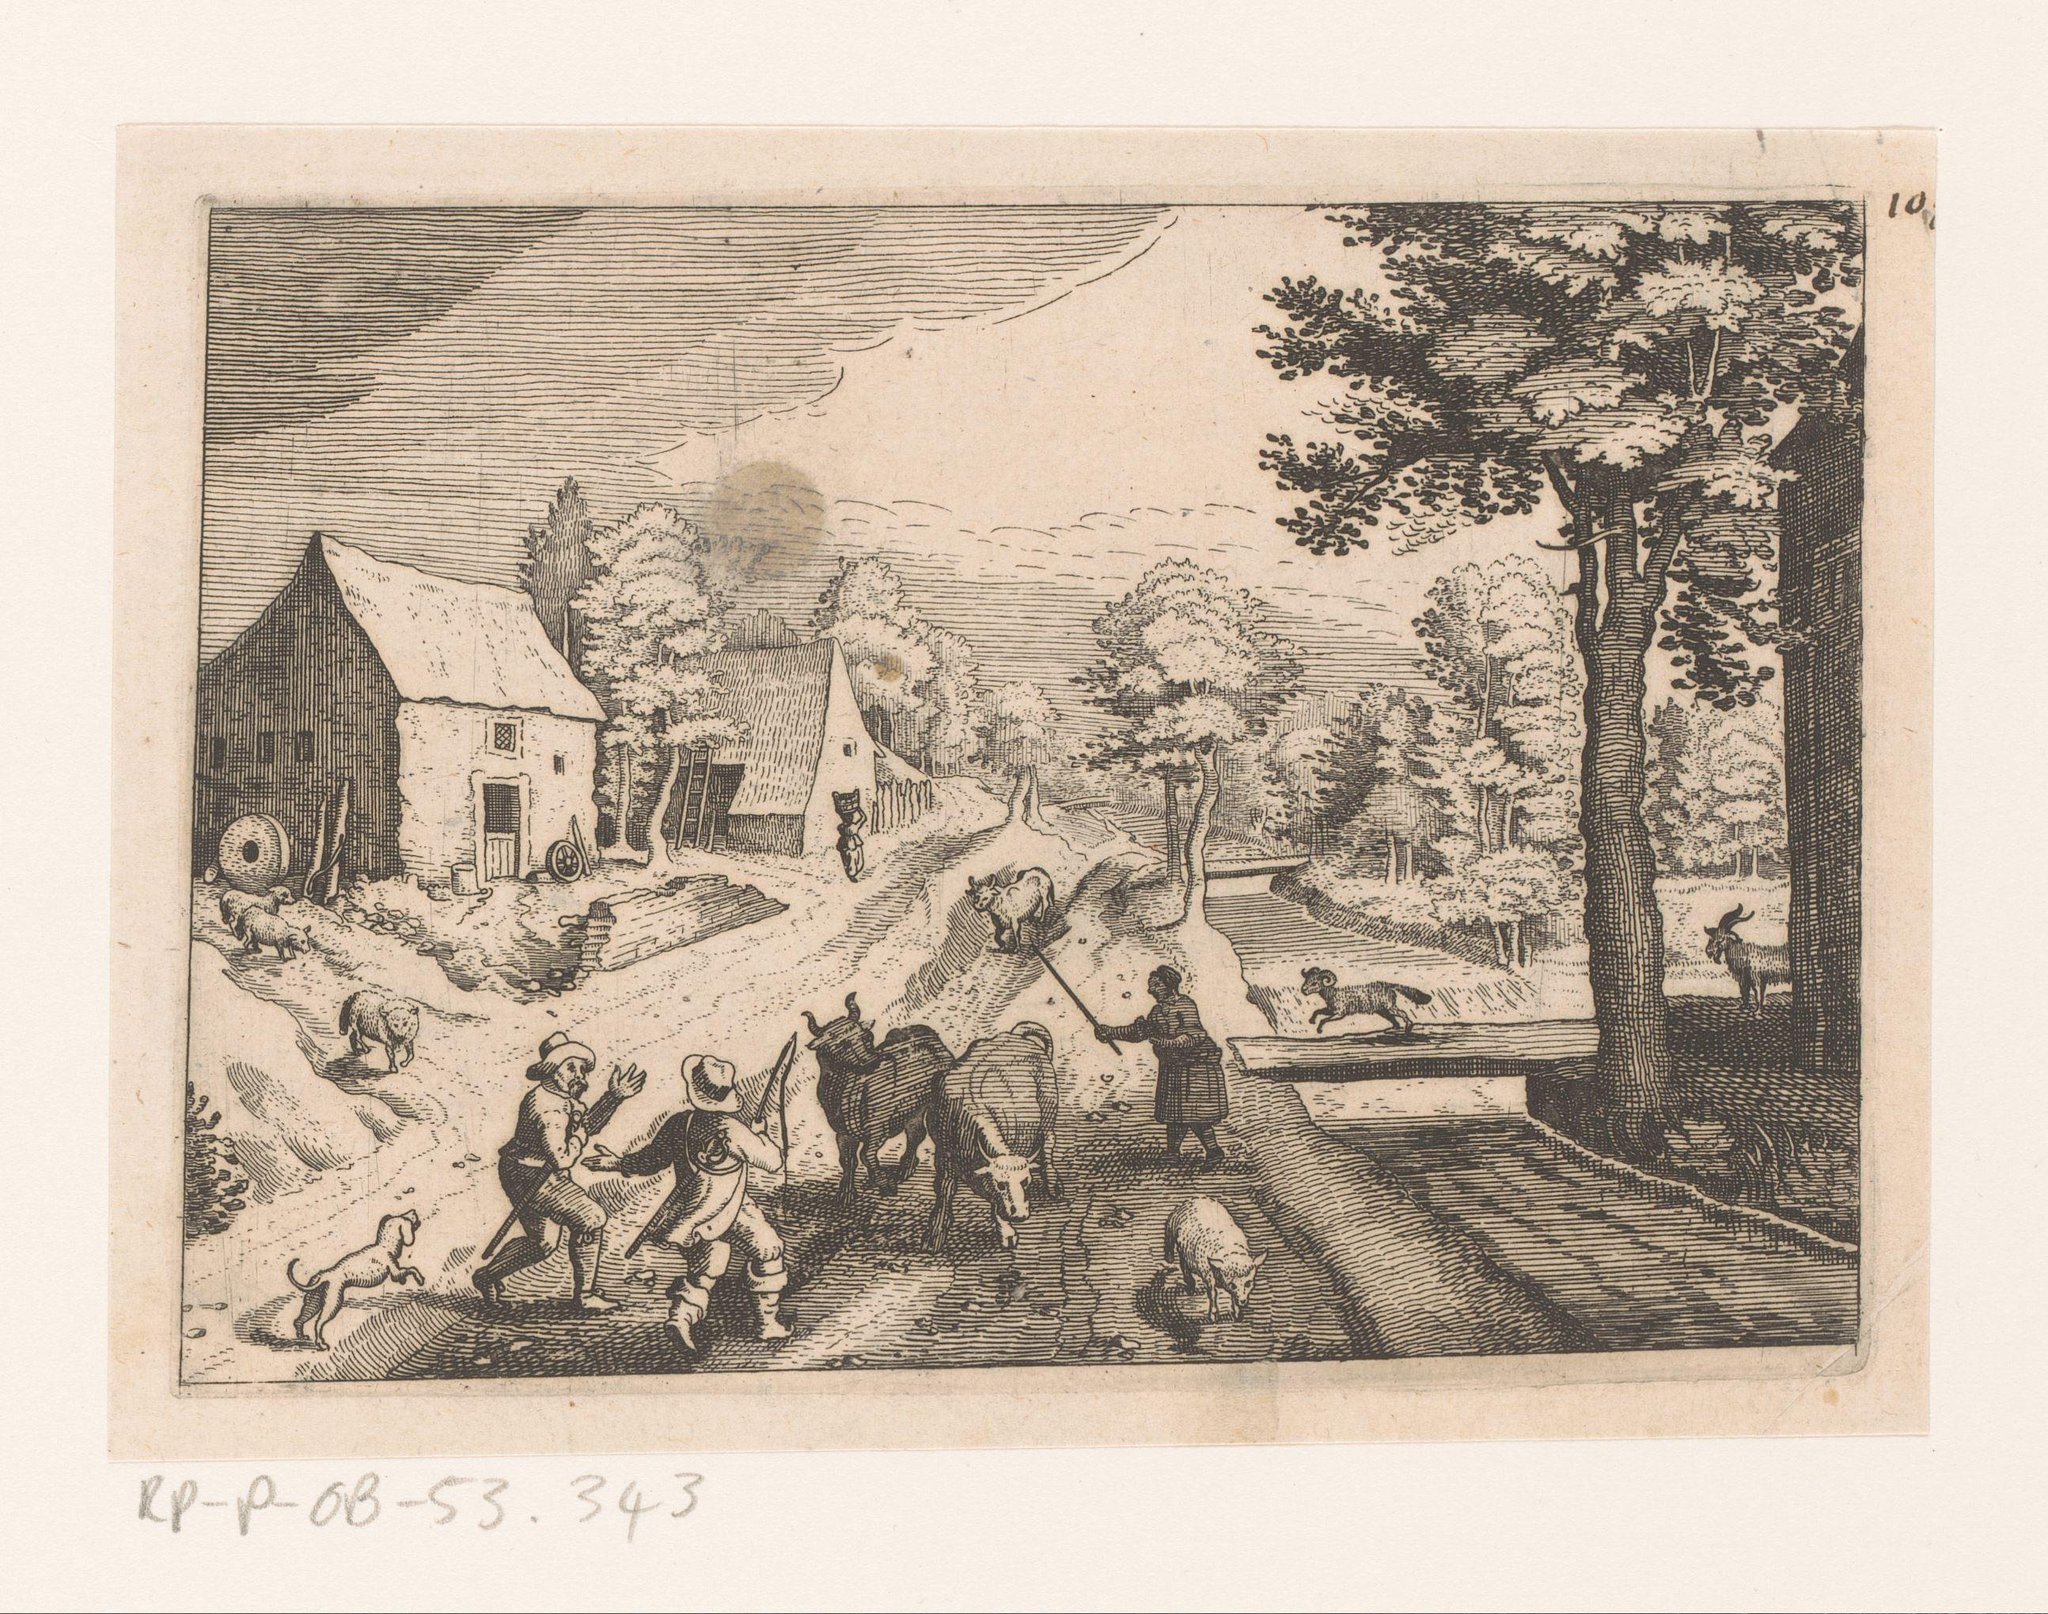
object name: print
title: Kopiëen naar de Schwalbacher Reise-serie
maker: Anonymous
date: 1620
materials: paper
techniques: etching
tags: river, village, road, path, cattle driving, cattle driver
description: Spiegelbeeldige kopie naar de prent van Matthäus Merian I (Hollstein 258).